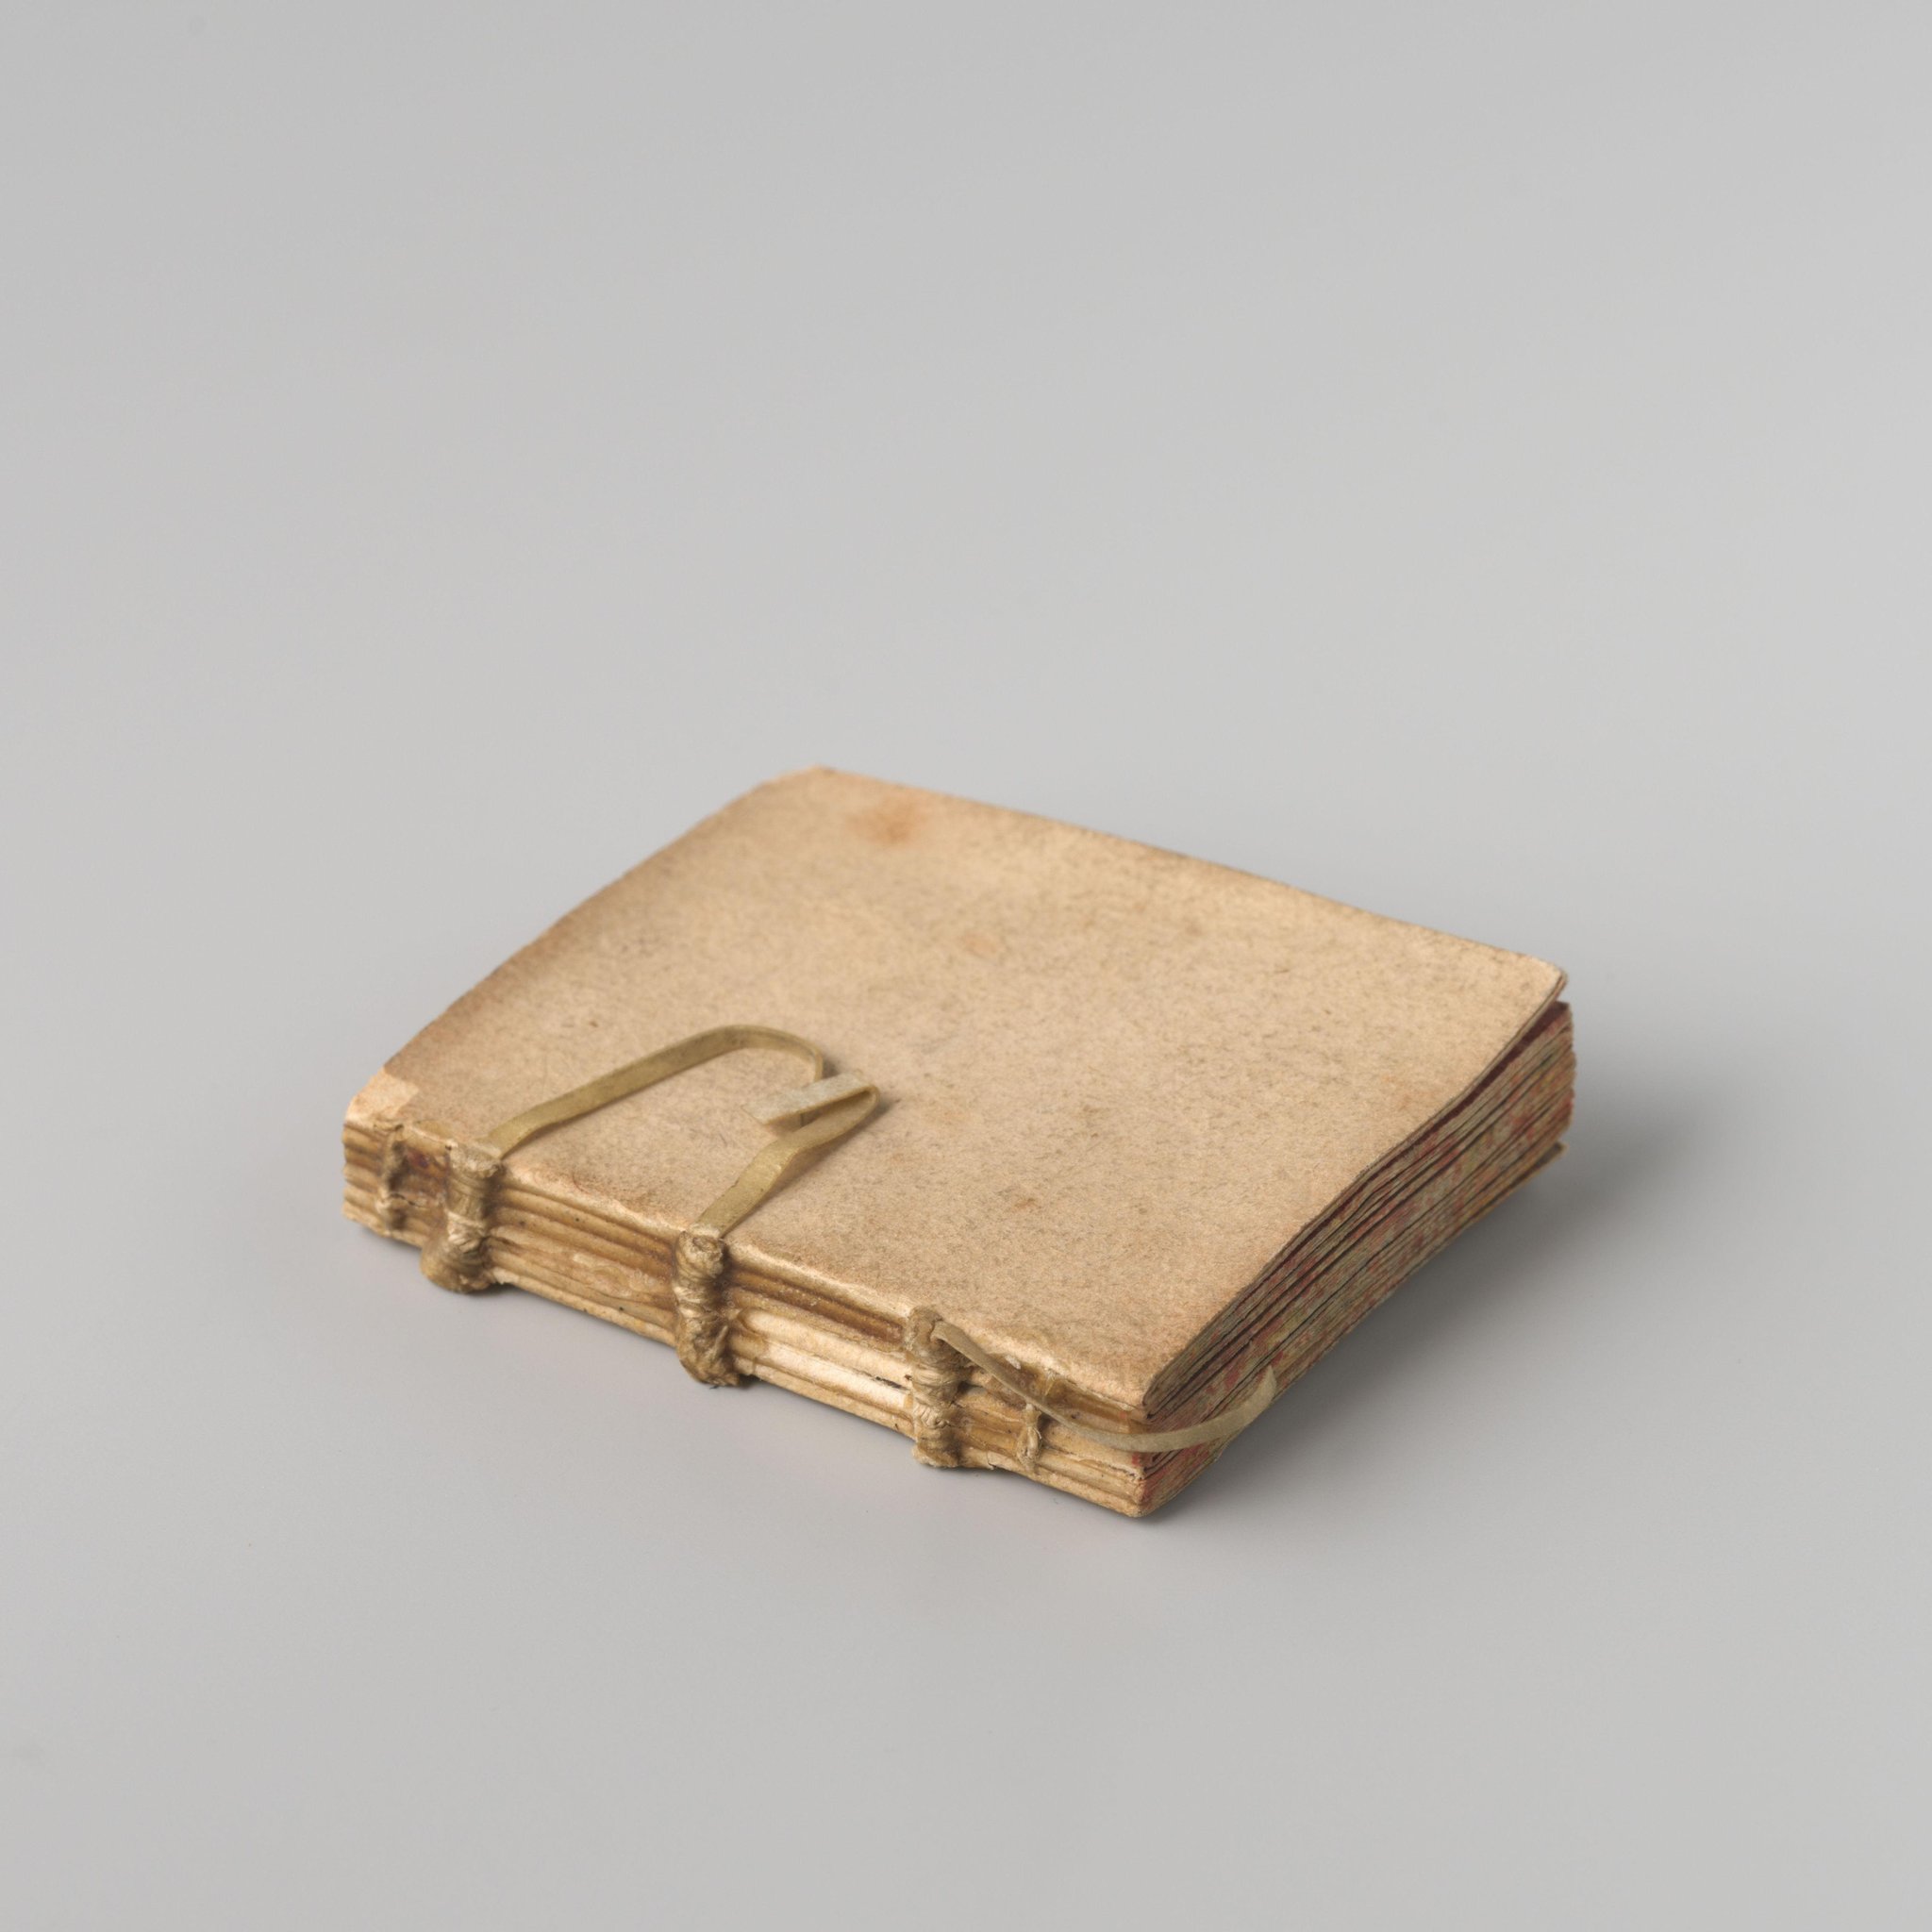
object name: book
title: Boekblok met stadsprofielen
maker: Anonymous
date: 1690-1710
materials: paper, parchment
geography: amsterdam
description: Boekblok met stadsprofielen. Het boekblok bestaat uit zes katernen van vier bladen, samengenaaid met draad en perkamenten boekriemen. De snede is gespat.